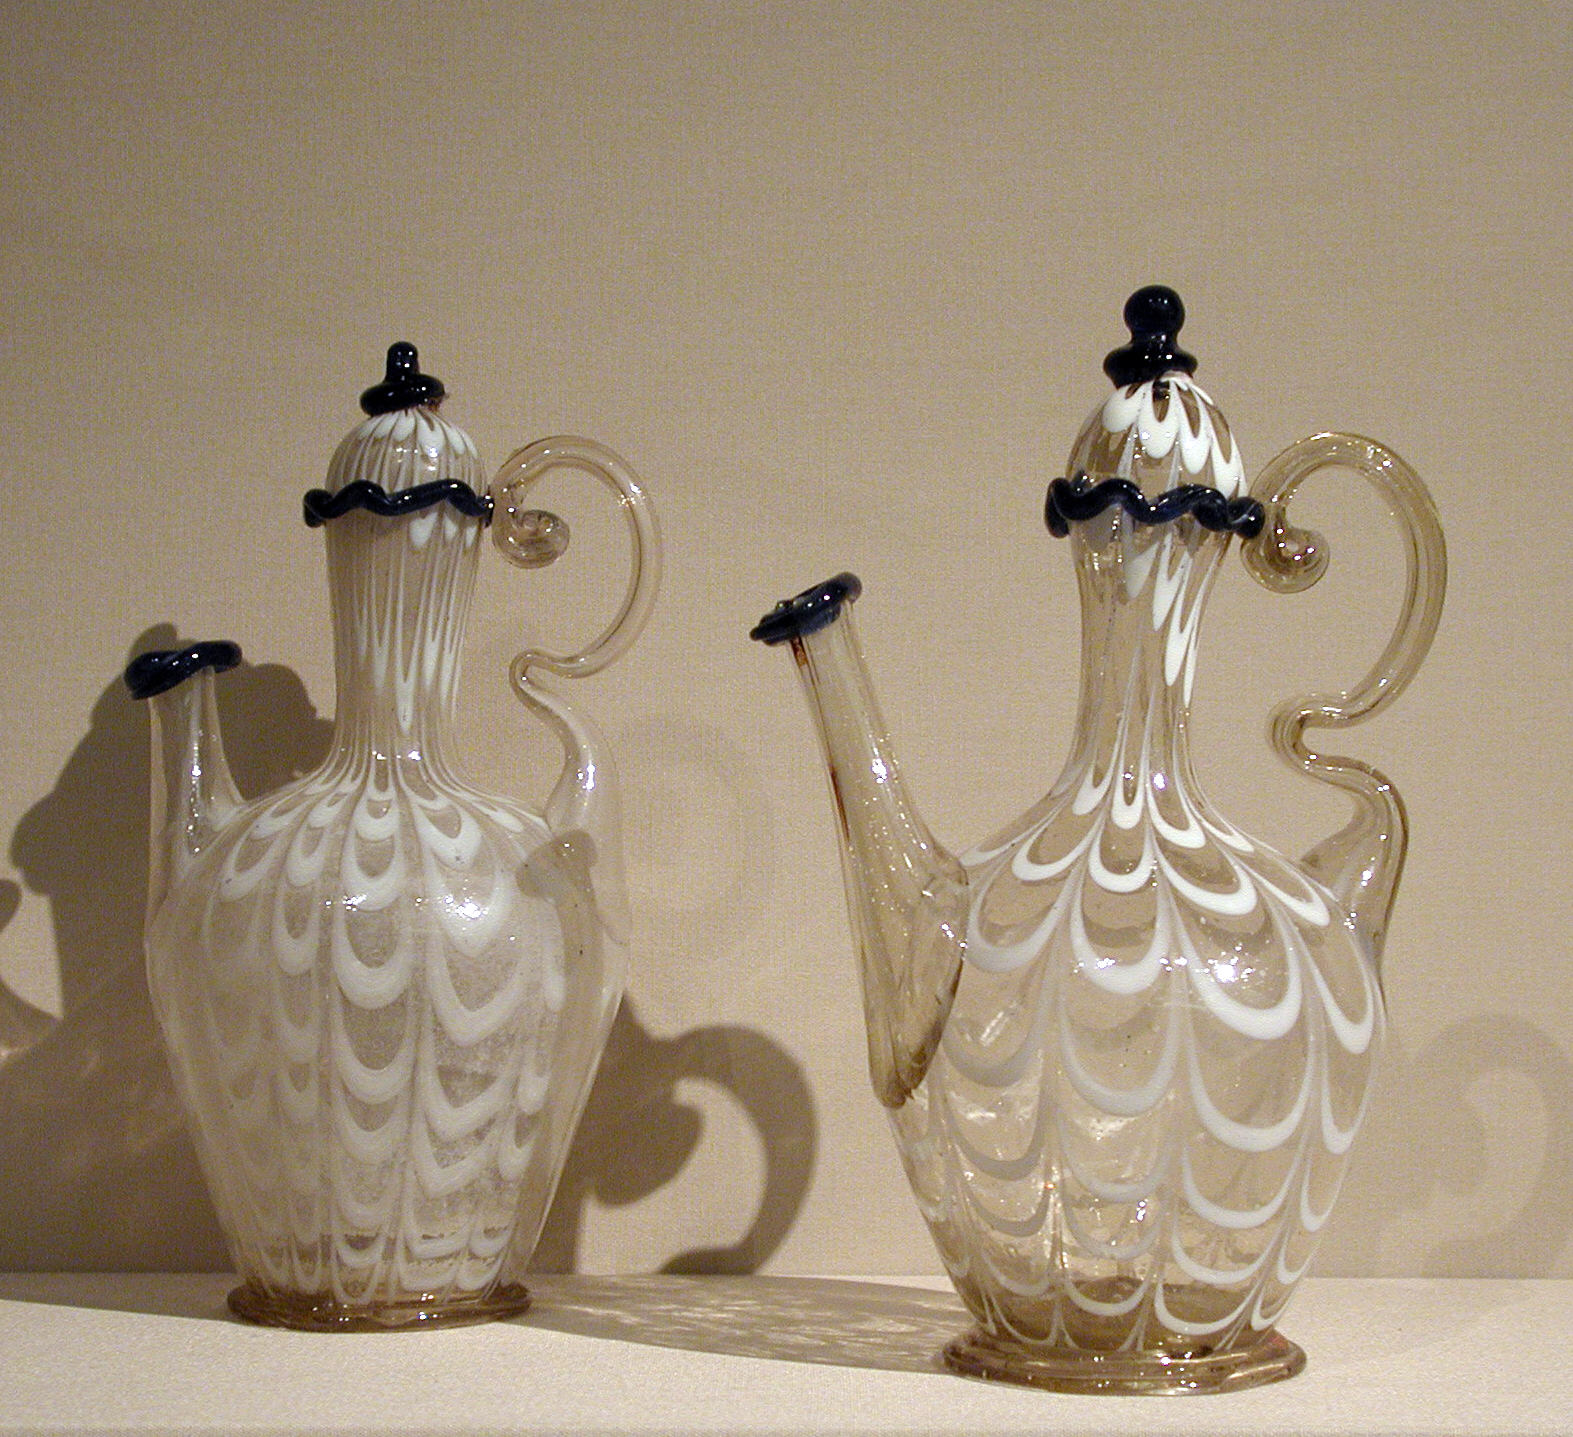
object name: biberon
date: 1601-1700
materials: glass